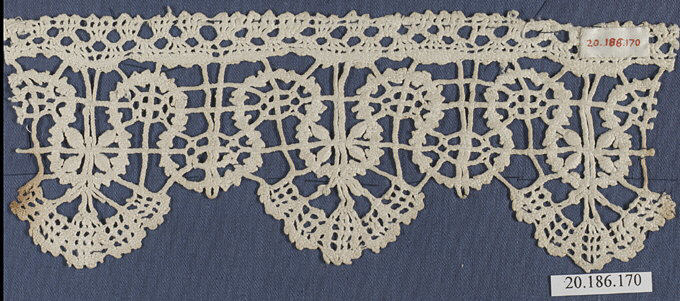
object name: edging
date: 1601-1700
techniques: lace